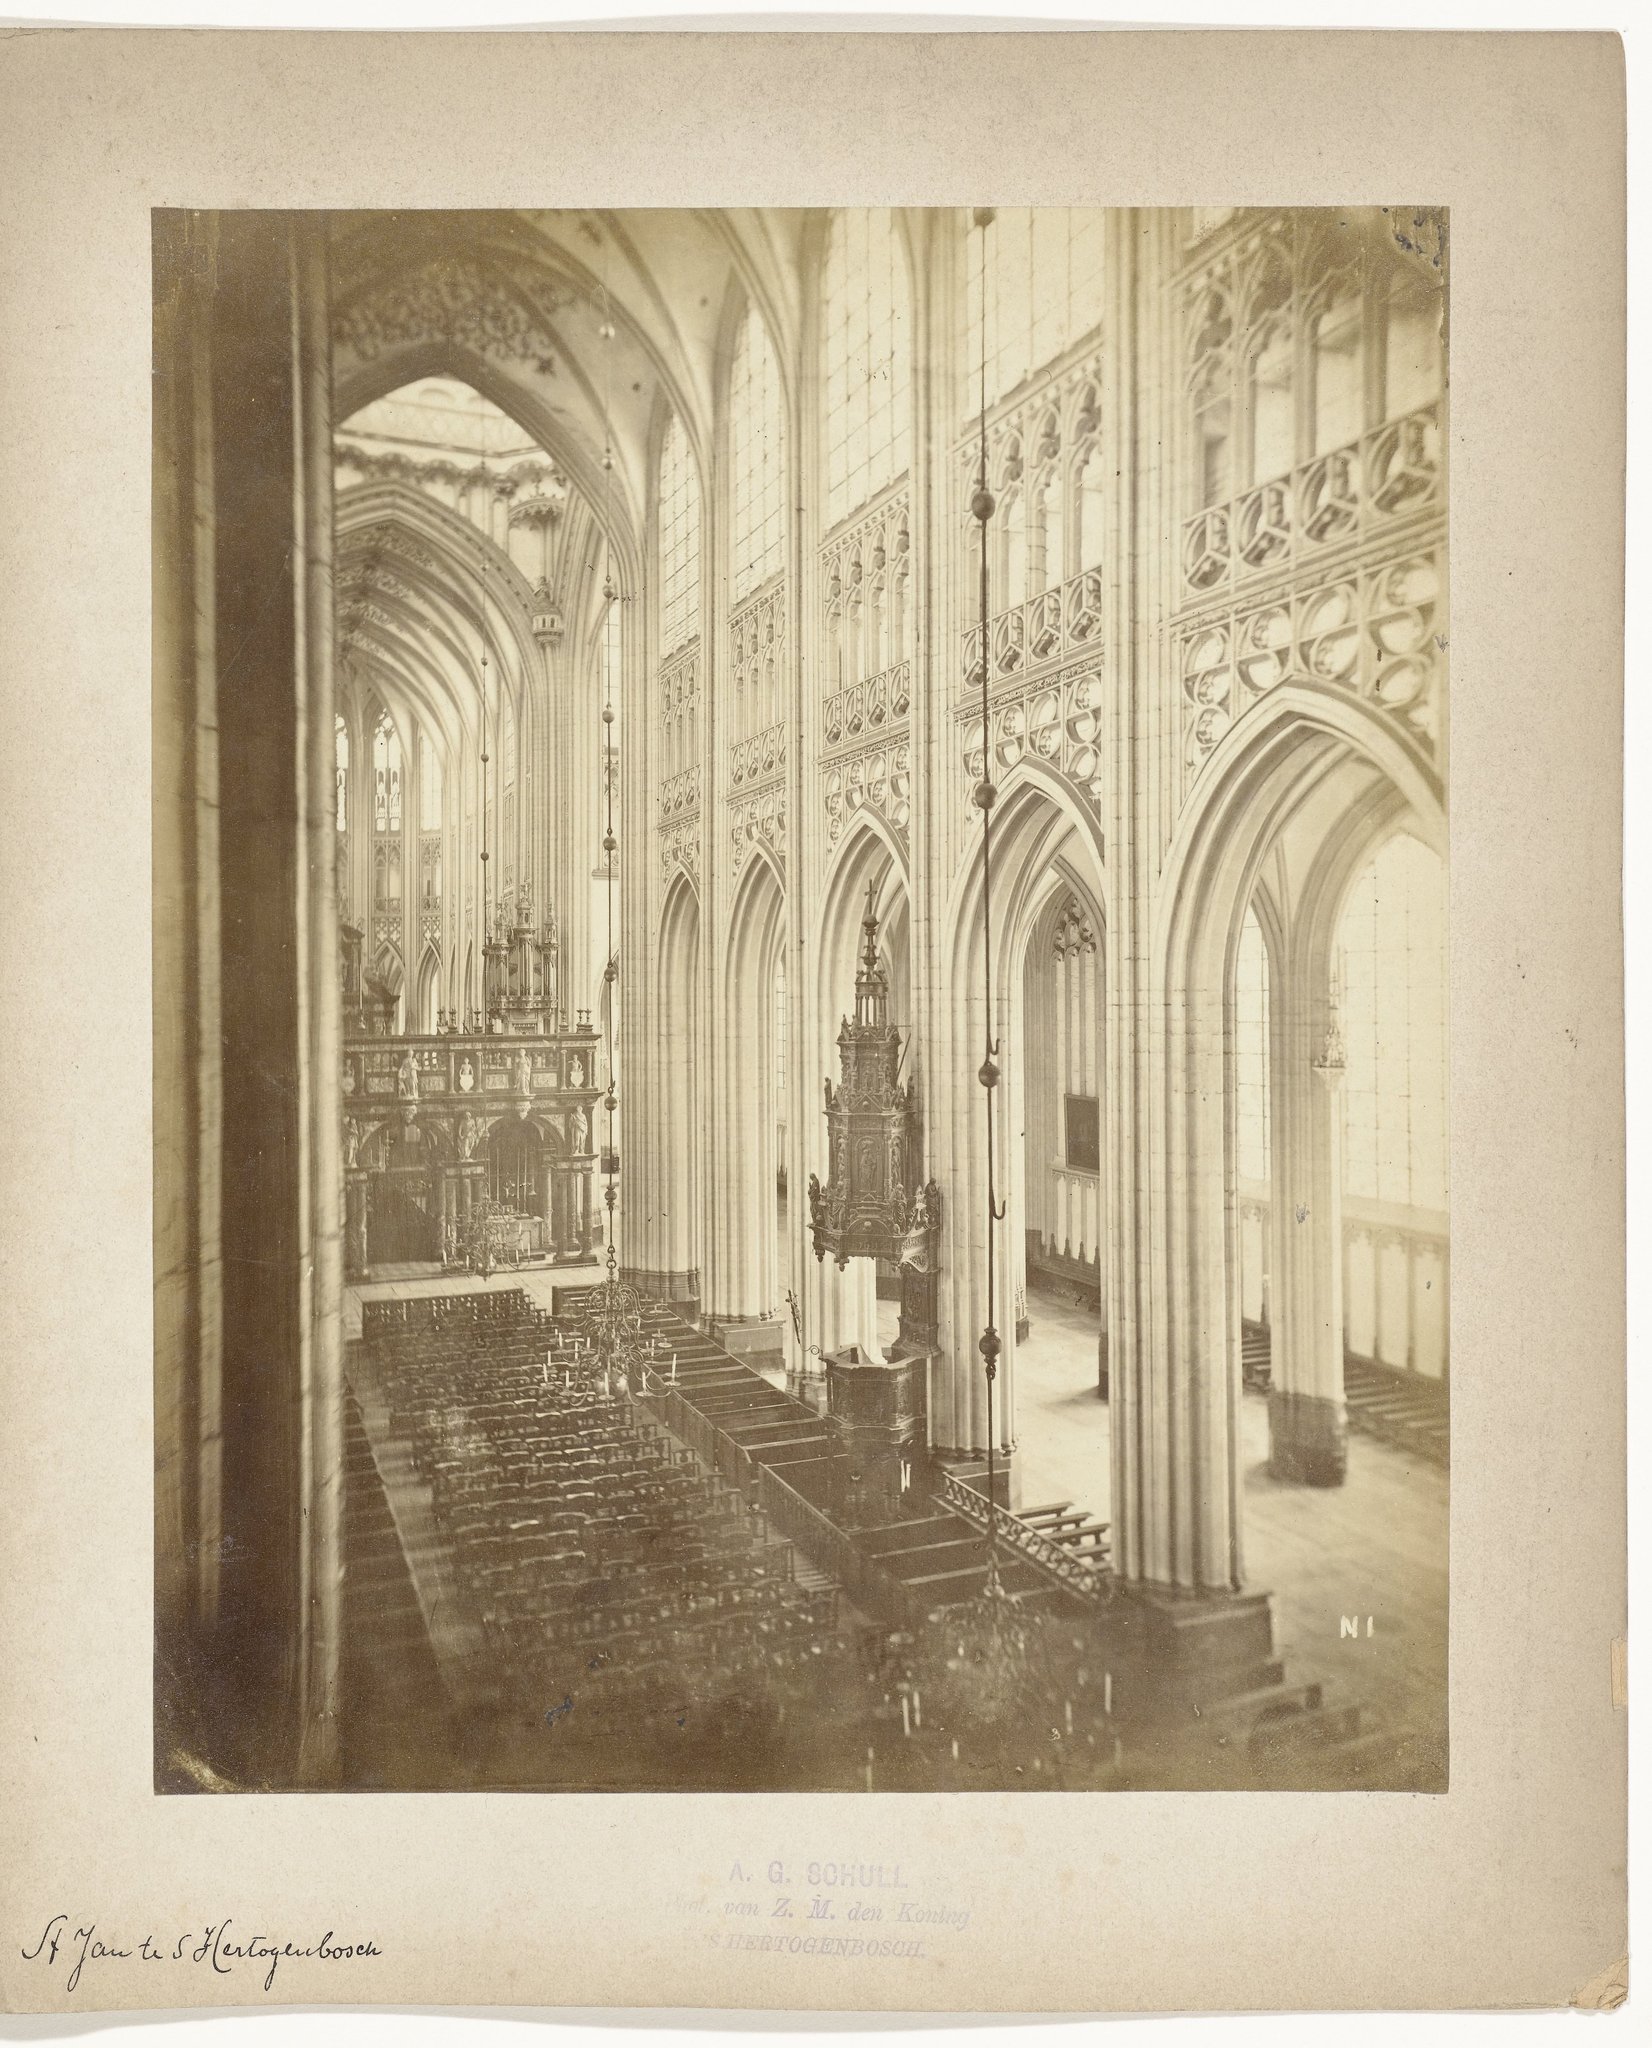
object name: photograph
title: St. Jan te 's-Hertogenbosch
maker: antonius godefridus schull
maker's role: fotograaf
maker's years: 1819-1896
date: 1865-1875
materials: cardboard, paper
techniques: albumen print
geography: den bosch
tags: interior of church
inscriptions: stamp: ‘A. G. Schull phot van Z.M. den Koning 's Hertogenbosch’